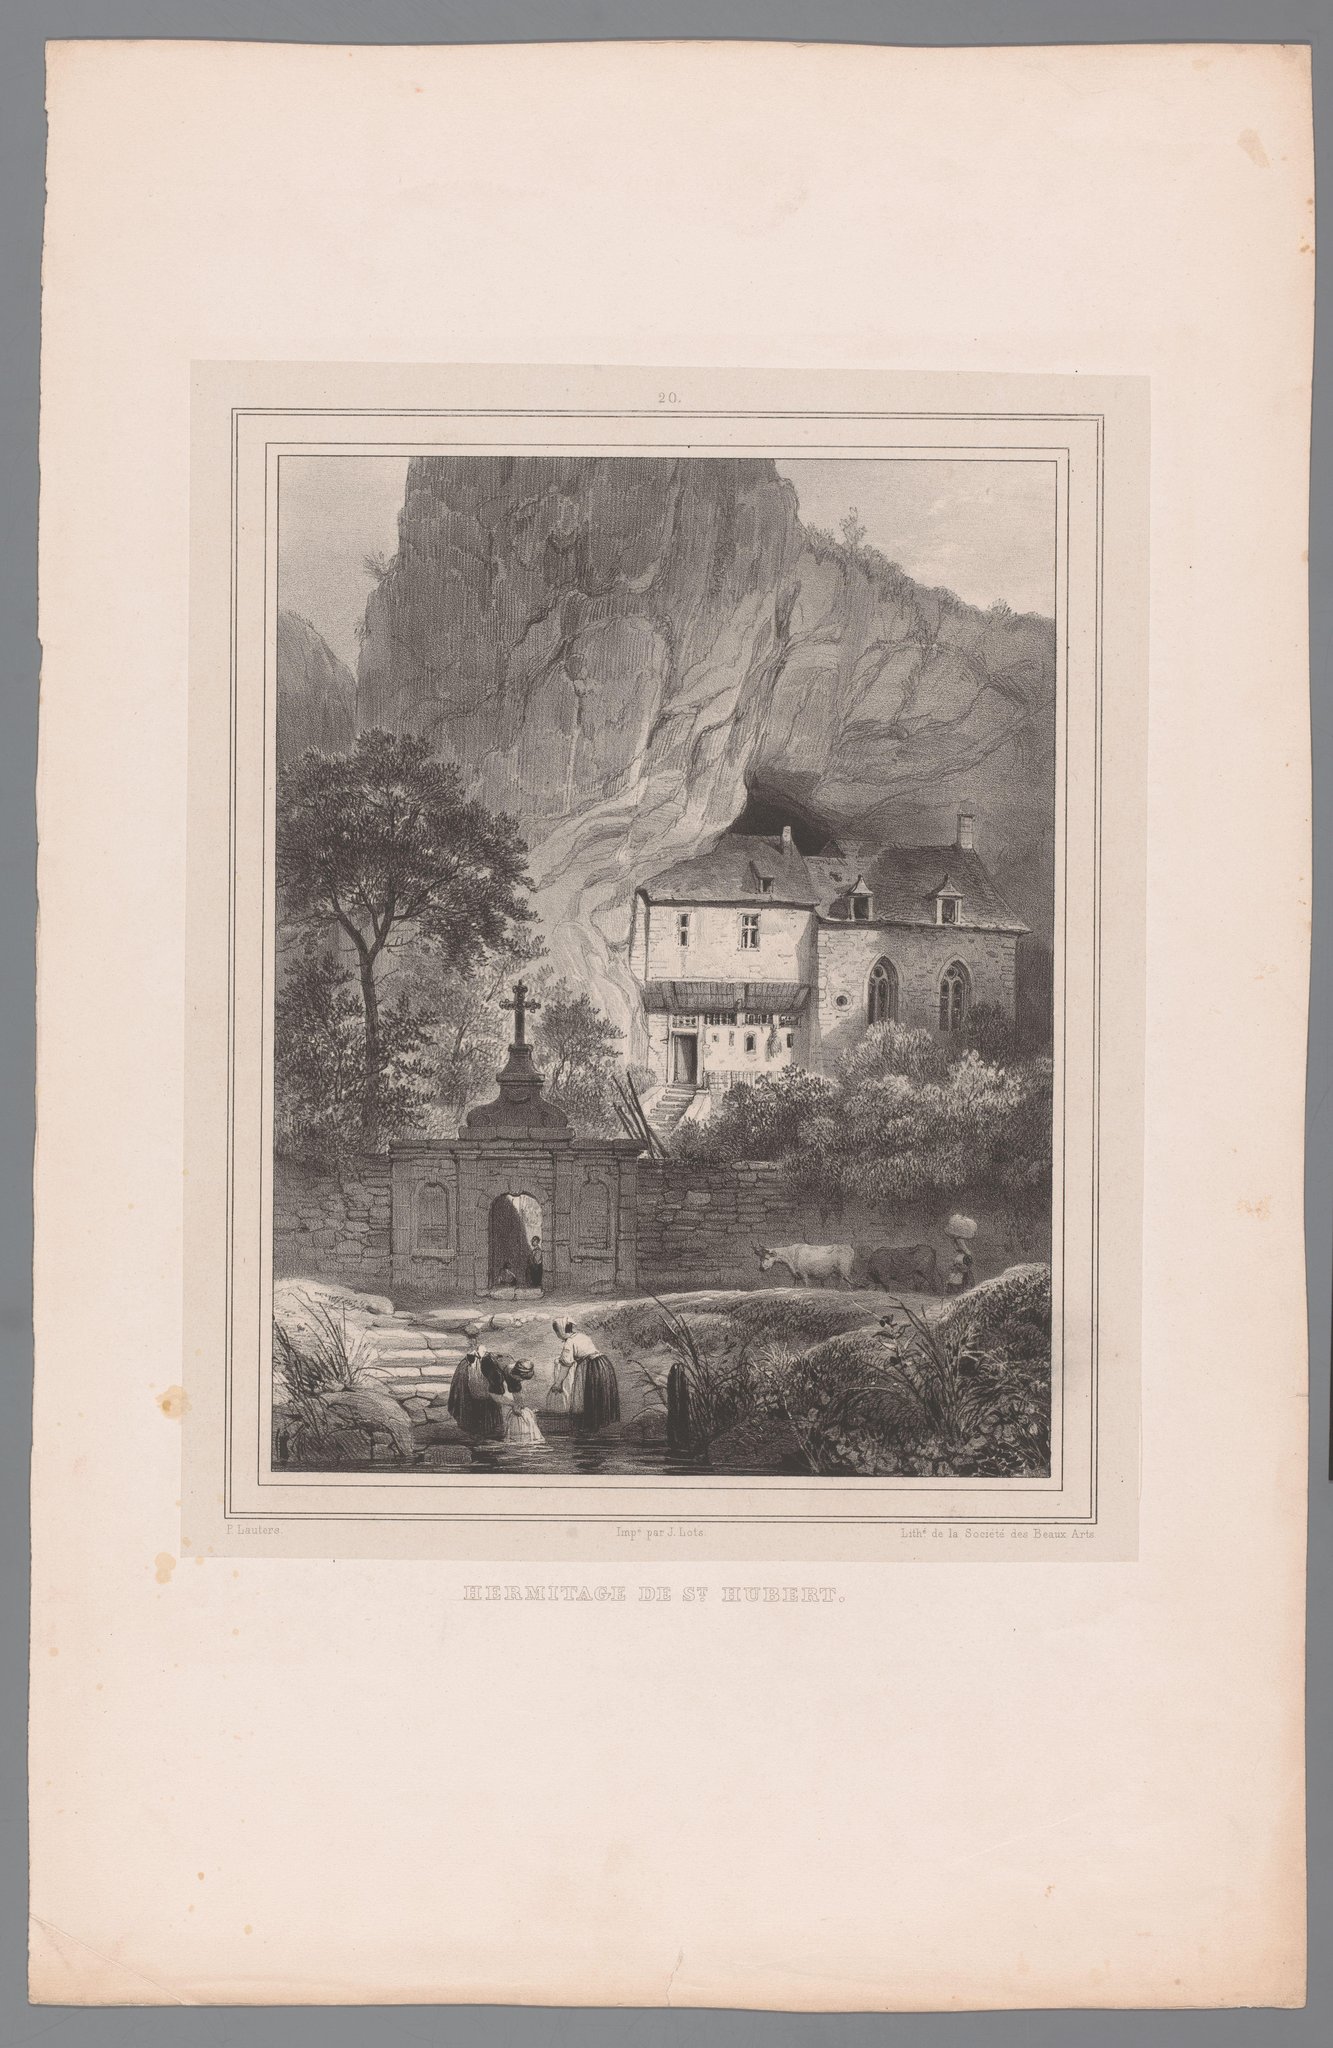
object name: print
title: Klooster in rots gebouwd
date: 1839-1841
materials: paper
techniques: lithograph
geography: brussels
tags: anchorite, hermit, cloisters ~ monastery, rocks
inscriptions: collector's mark: Lugt 2228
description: Prent verschenen in: Van Hasselt, André. Voyage aux bords de la Meuse. Brussel: Société des Beaux-Arts, 1839-1841. Deze publicatie bevat 36 litho's.